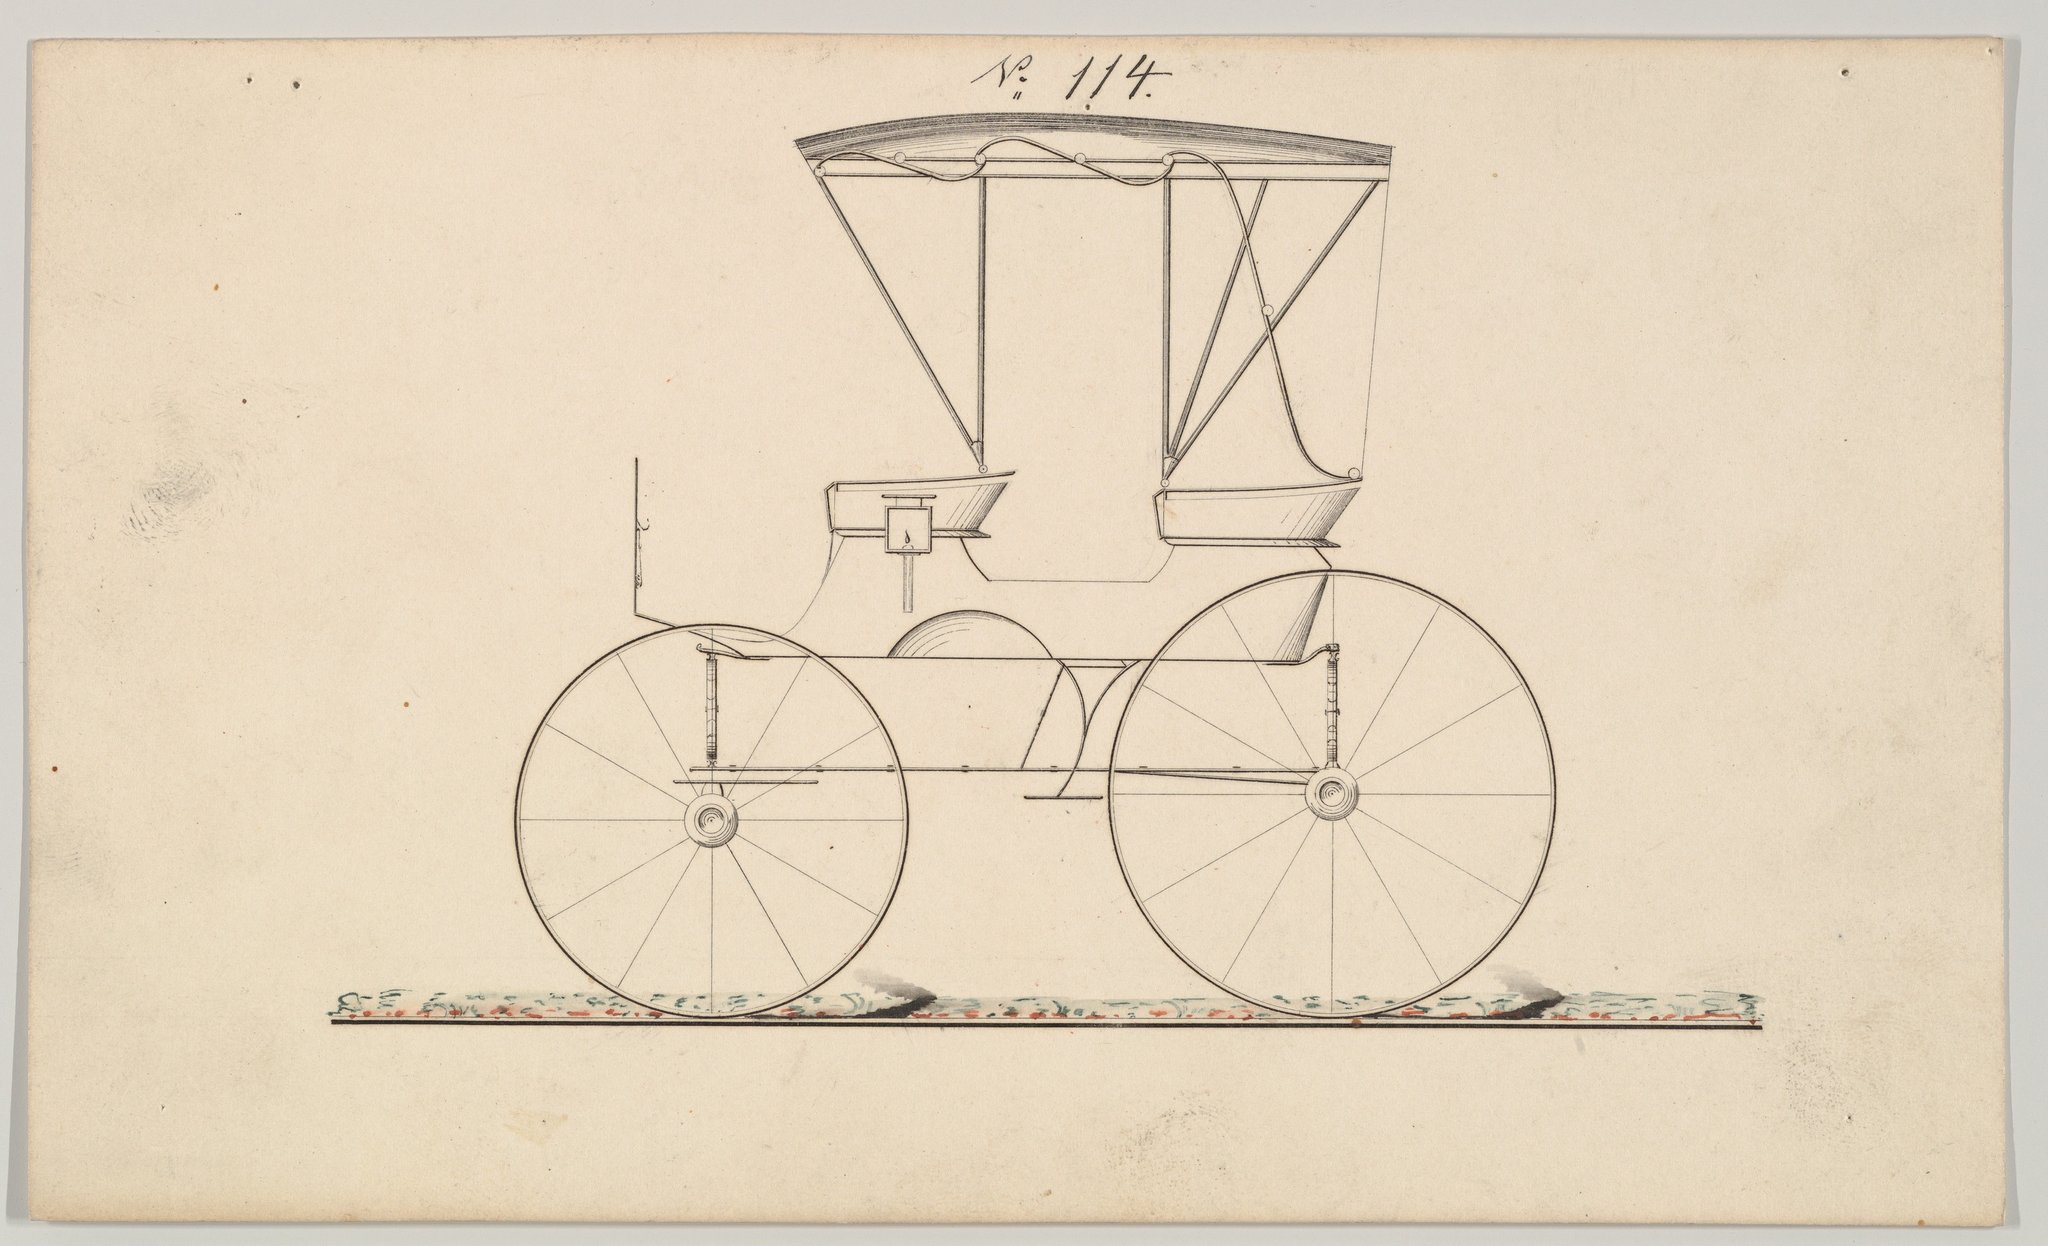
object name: drawing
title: Extension Top Phaeton #114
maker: brewster & co.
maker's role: manufacturer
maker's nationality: american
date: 1865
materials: ink, watercolor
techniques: pen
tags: carriages